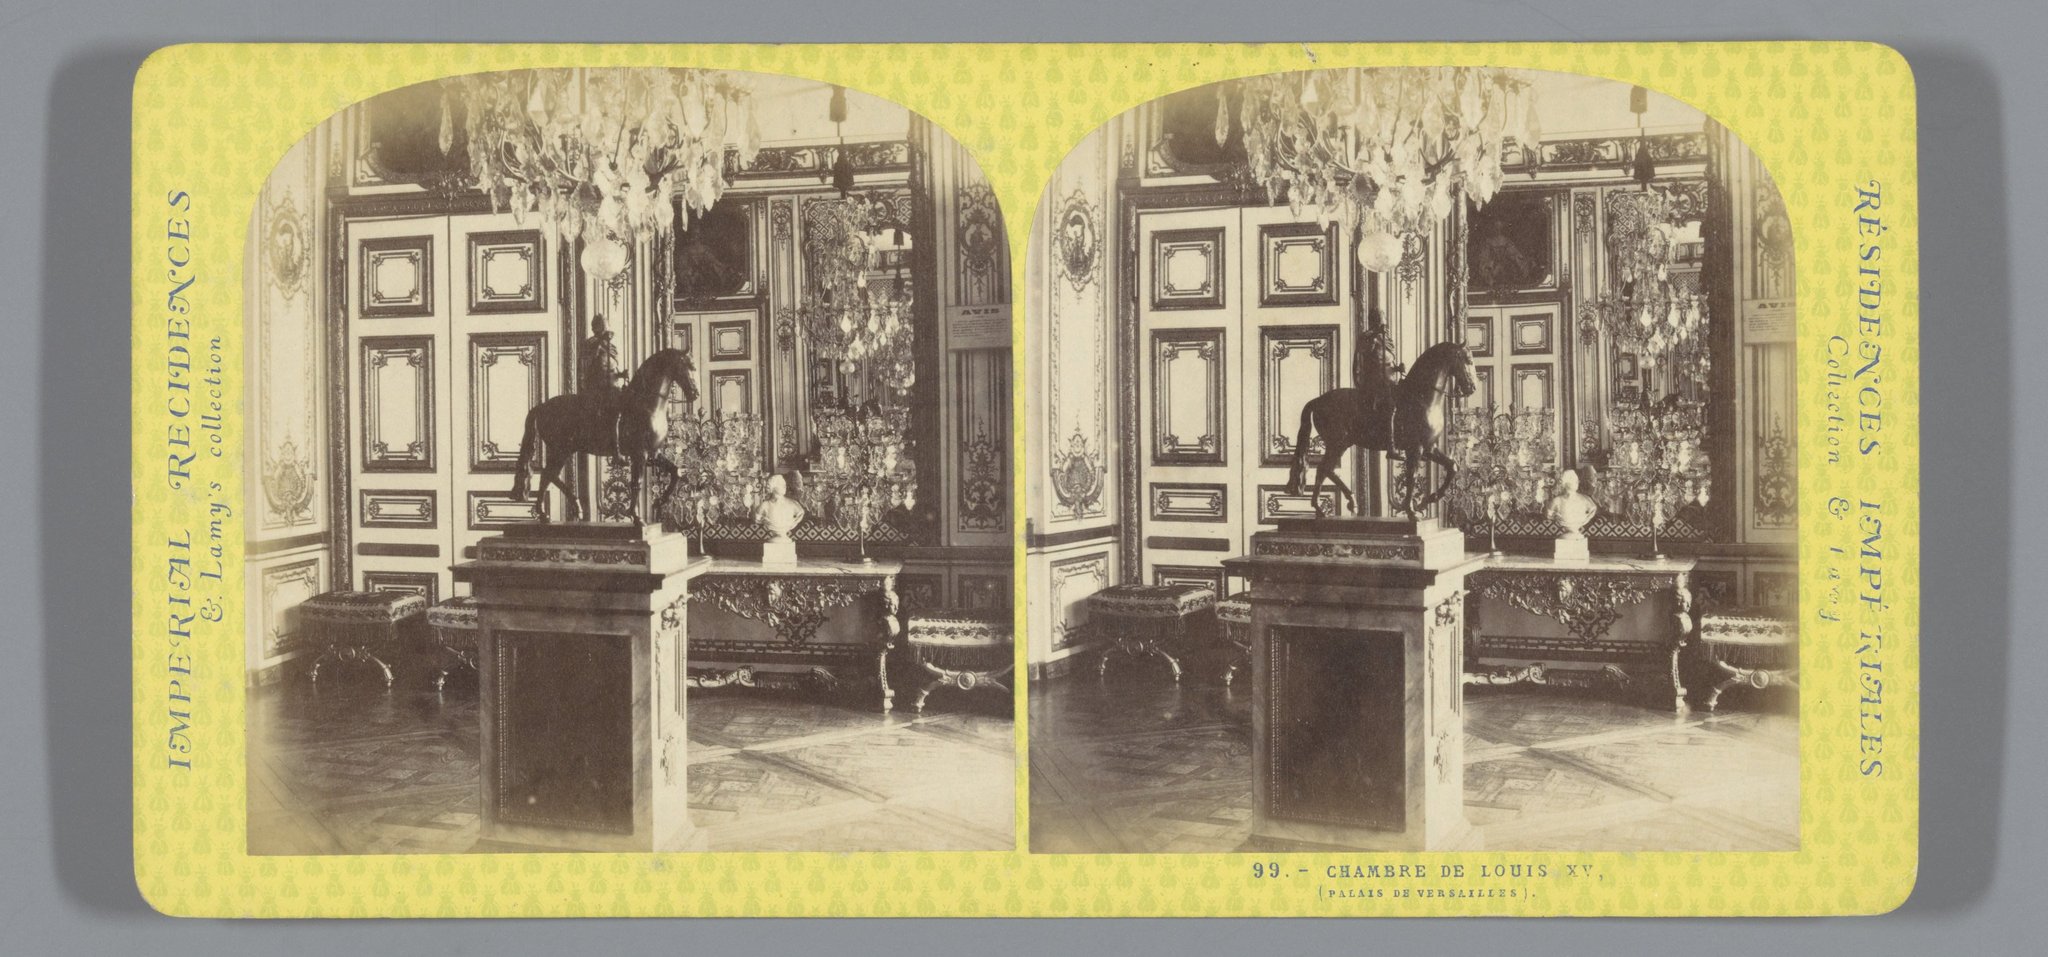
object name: stereograph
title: Chambre de Louis XV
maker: ernest eléonor pierre lamy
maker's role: publisher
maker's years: 1828-1900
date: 1860-1880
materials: cardboard, photographic support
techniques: albumen print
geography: versailles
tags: palace, interior ~ representation of a building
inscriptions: inscription: ‘E. Lamy's collection’, number: ‘99.’